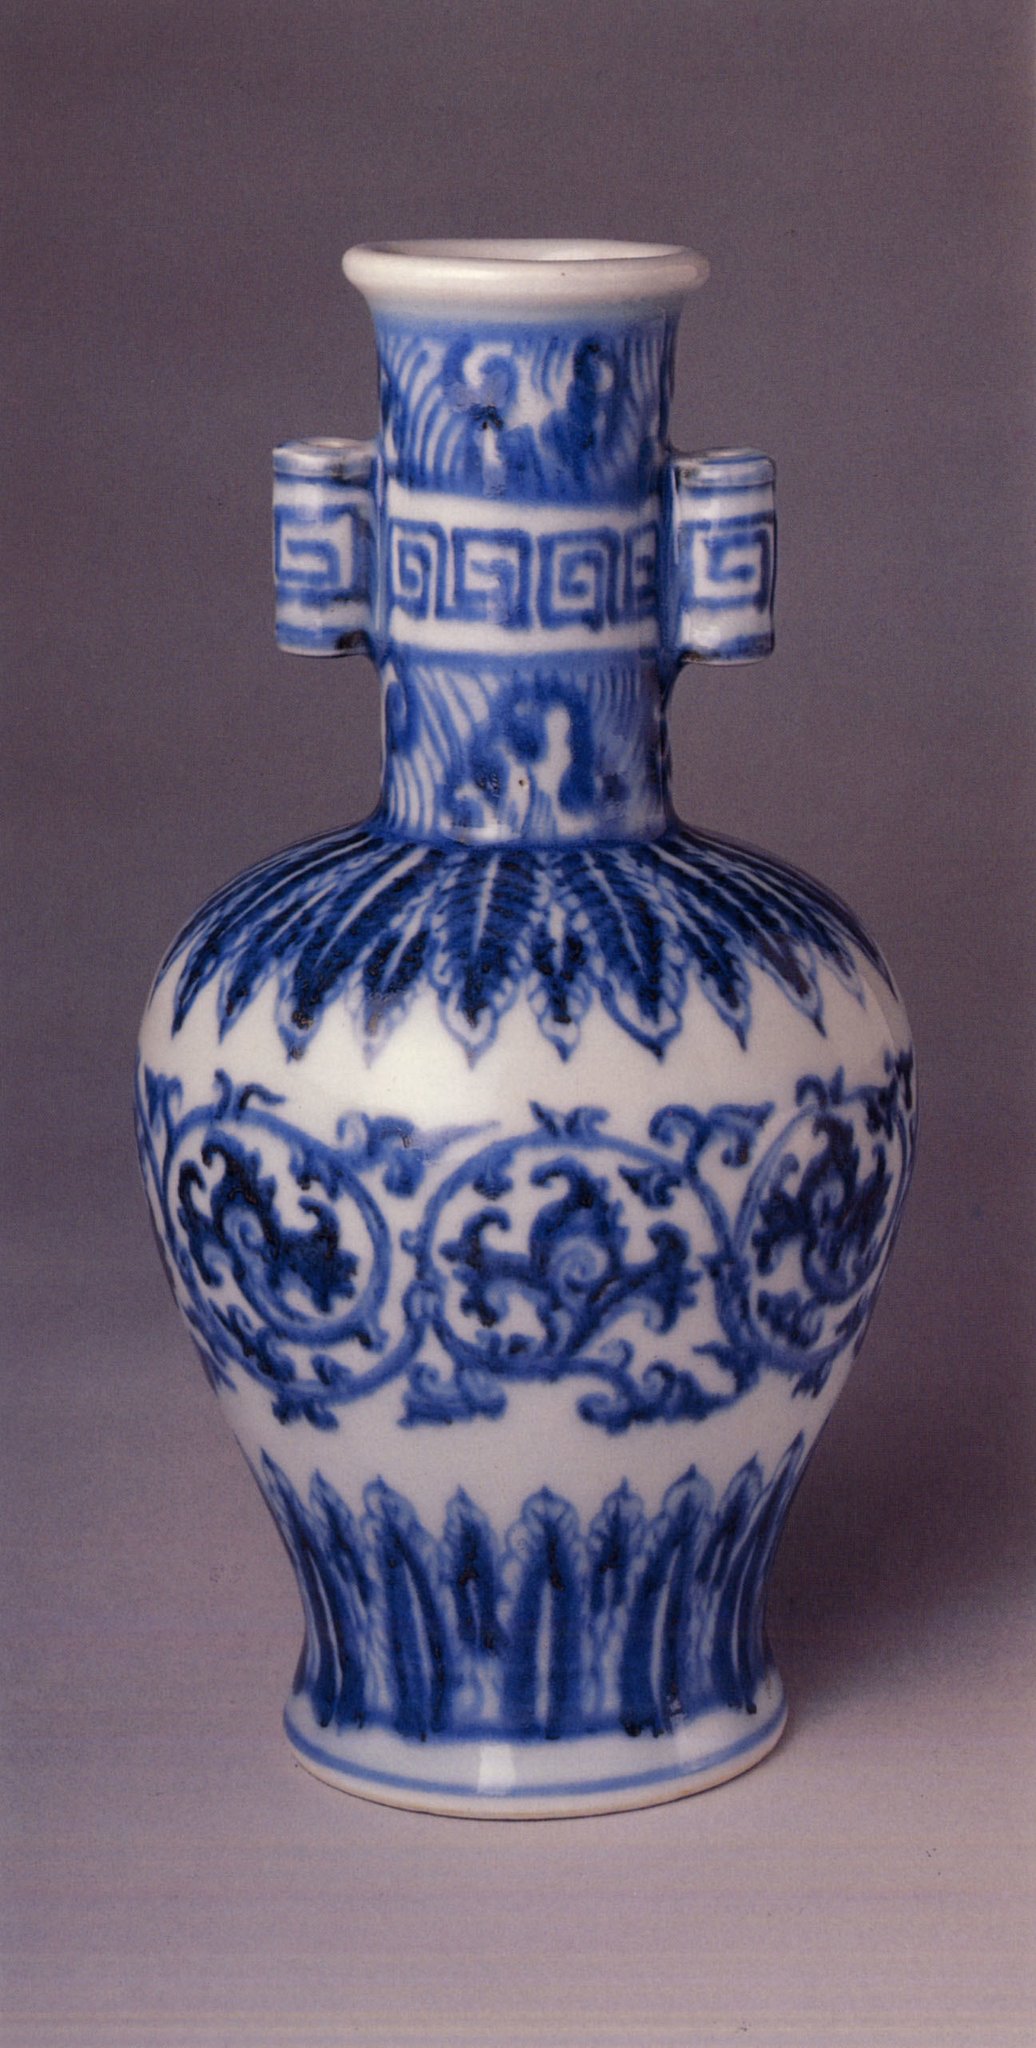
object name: vase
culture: chinese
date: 1426-1435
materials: cobalt, glaze, porcelain